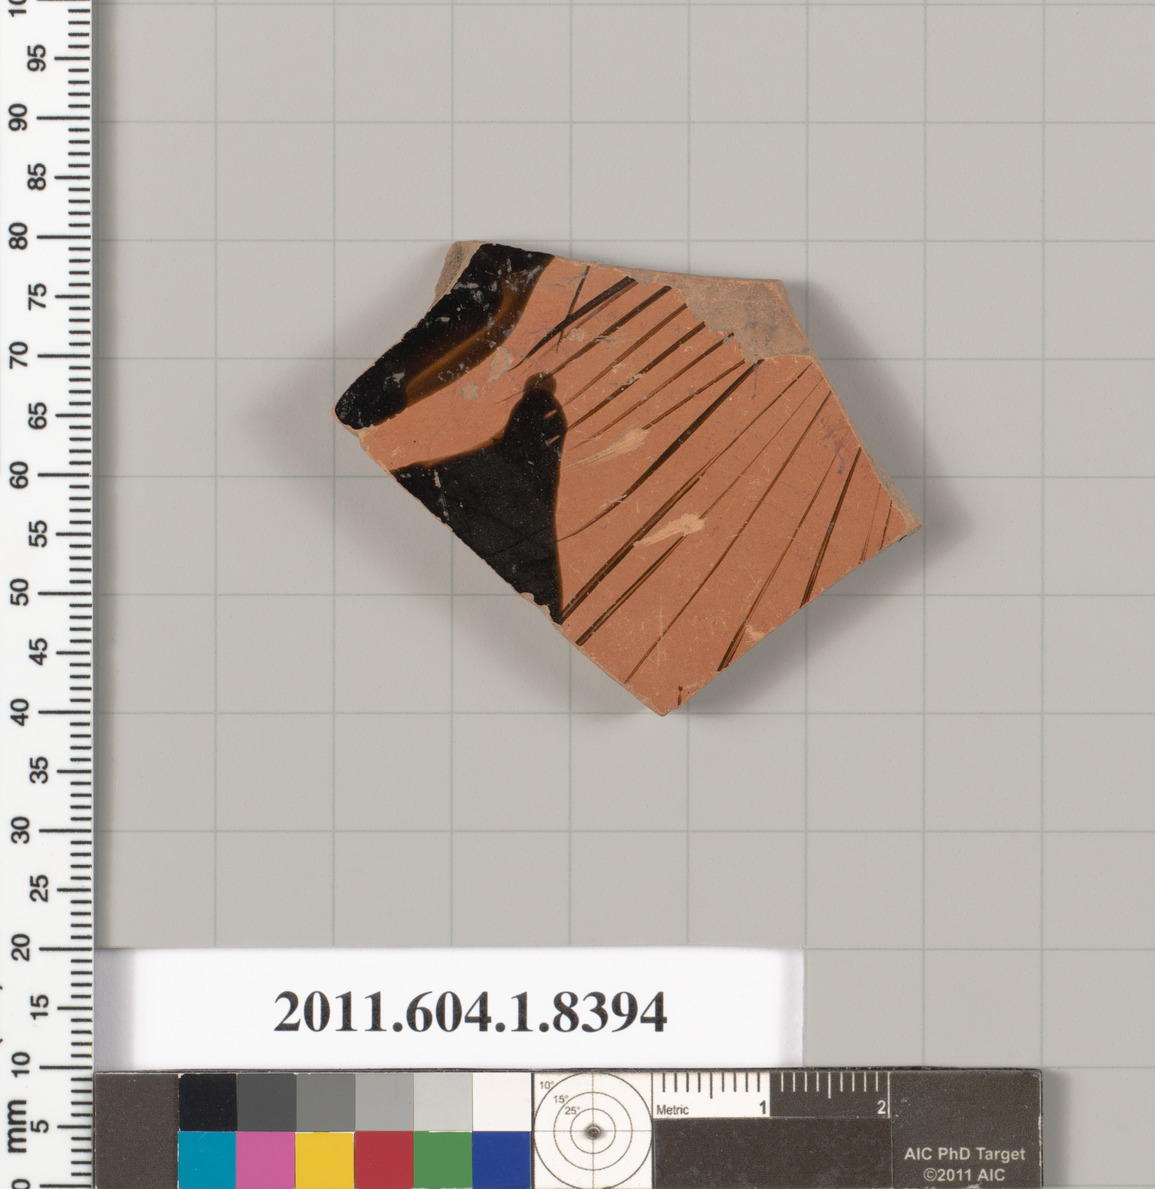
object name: kylix fragment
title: Terracotta fragment of a kylix (drinking cup)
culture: greek, attic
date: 400-351 BCE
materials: terracotta